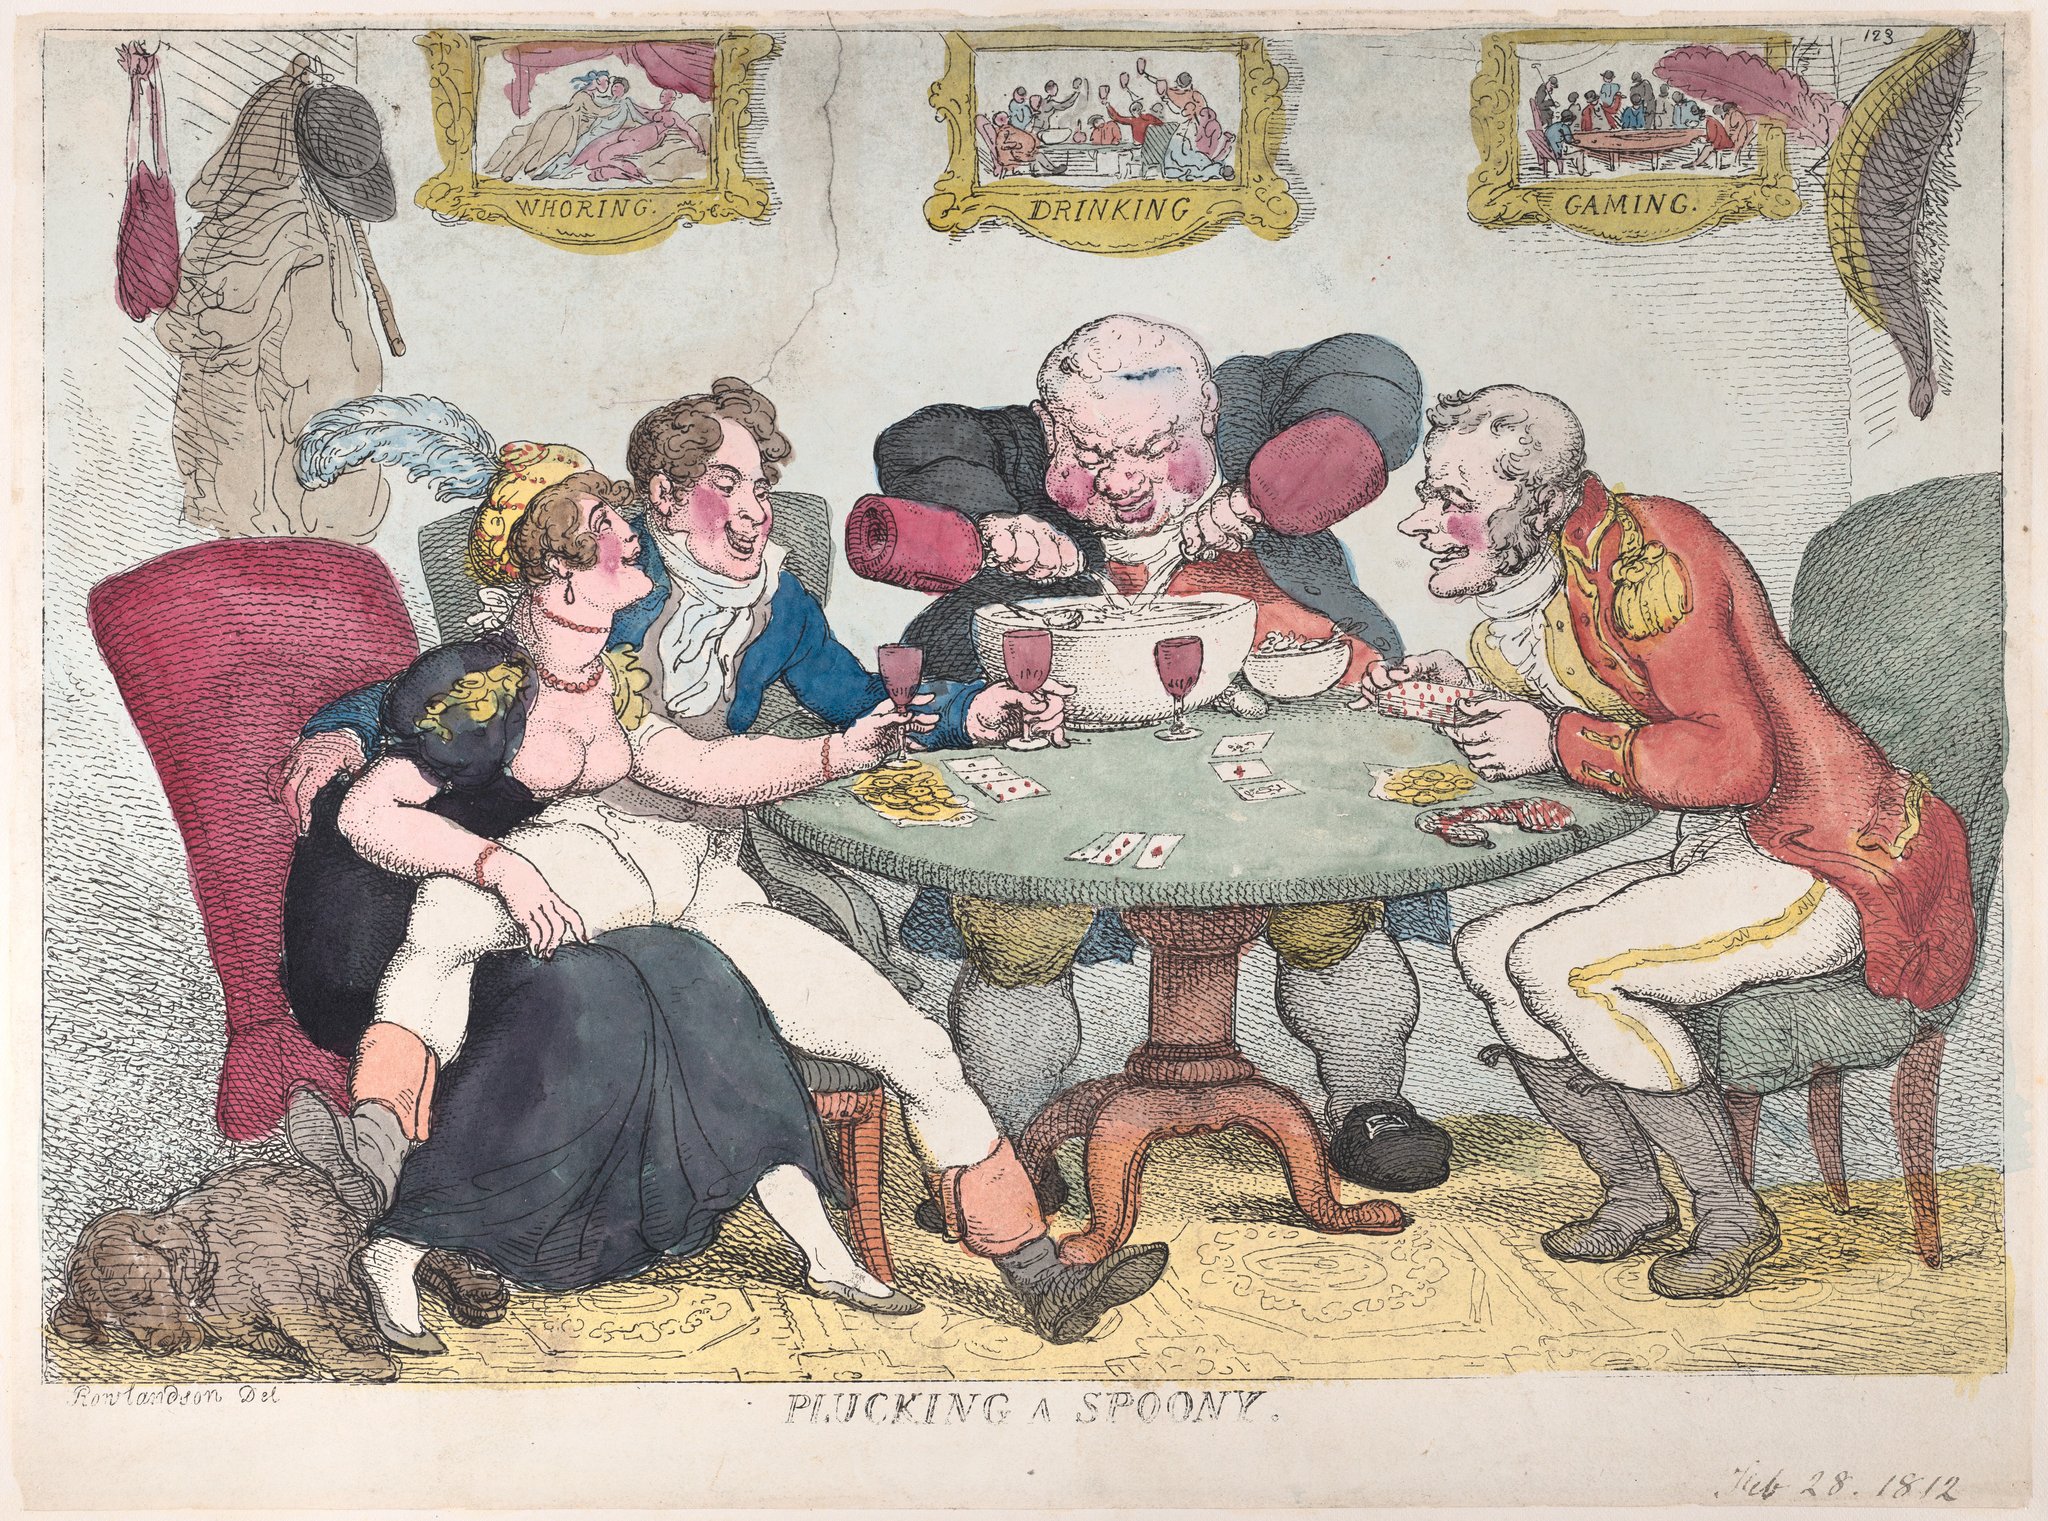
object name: print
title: Plucking a Spoony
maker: thomas rowlandson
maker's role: artist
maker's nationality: british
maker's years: 1757-1827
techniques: etching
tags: satire,men,women,gambling,playing cards,drinking